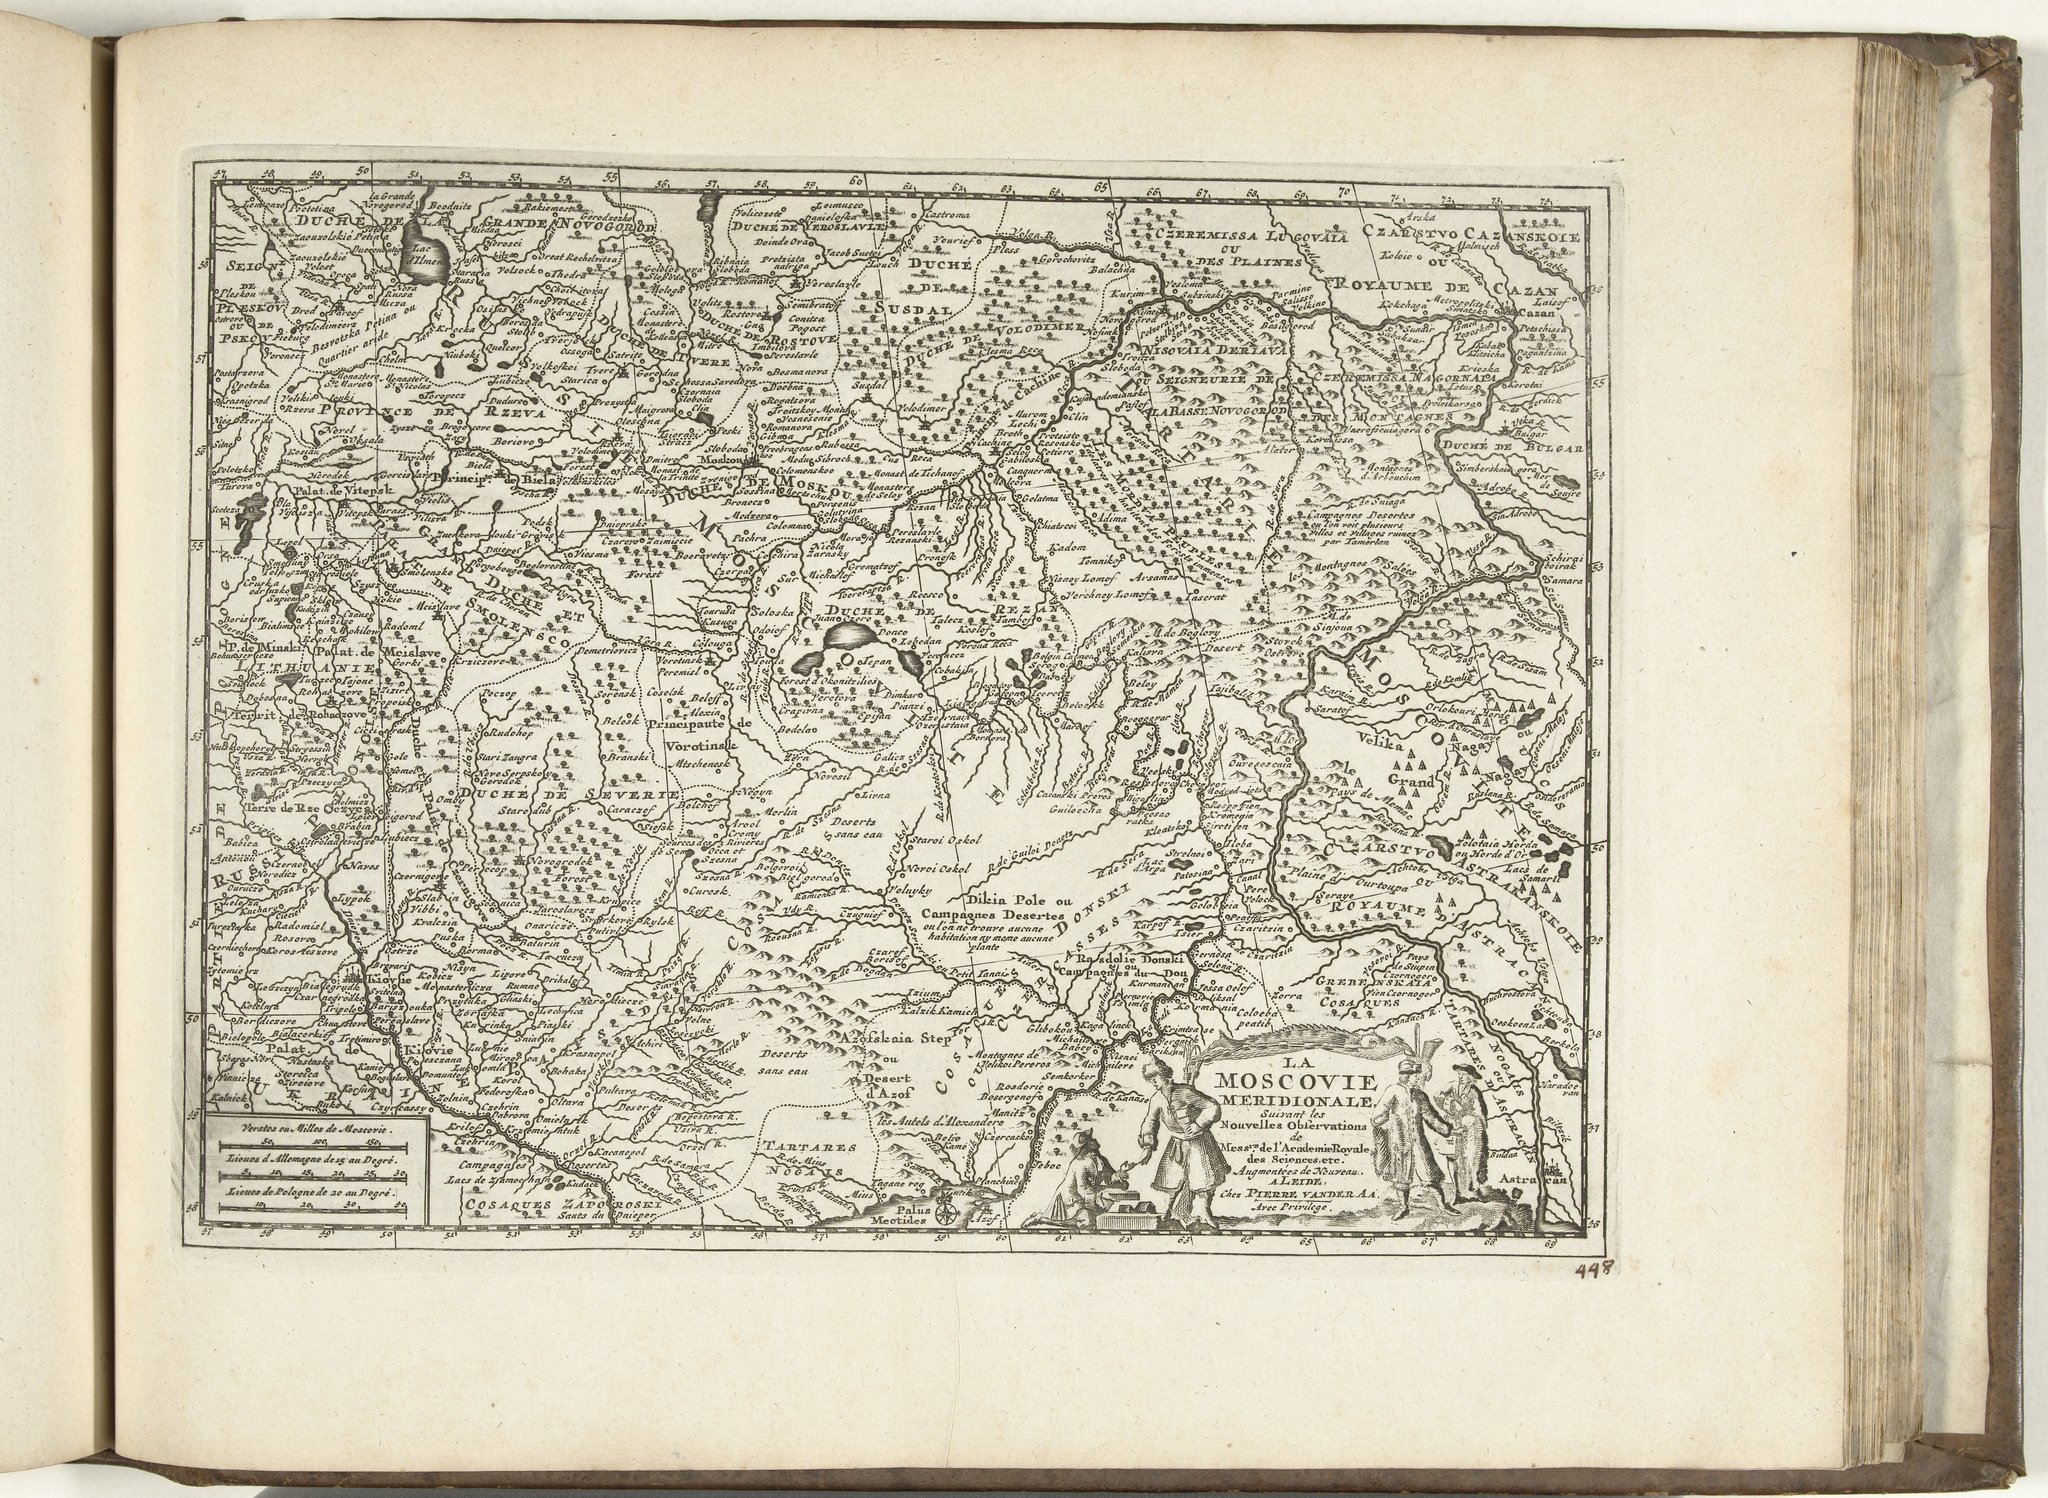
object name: map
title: La Moscovie Meridionale, Suivant les Nouvelles Observations (...)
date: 1726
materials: paper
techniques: engraving, etching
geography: northern netherlands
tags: maps of separate countries or regions, russia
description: Kaart van Moskovië, het deel van Rusland rond Moskou. Plaat nr. 448 in deel XVIII van het prentwerk: Les Forces de l'Europe, Asie, Afrique et Amerique ... Comme aussi les Cartes des Côtes de France et d'Espagne uit 1726, dit tweede deel met 271 met de hand genummerde platen van vermaarde sterke steden en vestingen in het kader van de Spaanse Successieoorlog 1701-1713. Voor het merendeel zijn deze platen gekopieerd naar de anonieme Franse platen van vermaarde sterke steden en vestingen: in Les forces de l'Europe en in: Le theatre de la guerre, dans les Pays-Bas, beide oorspronkelijk uitgegeven door Nicolas de Fer te Parijs (1693-1697) in het kader van de Negenjarige Oorlog. Titel en opschriften in het Frans.